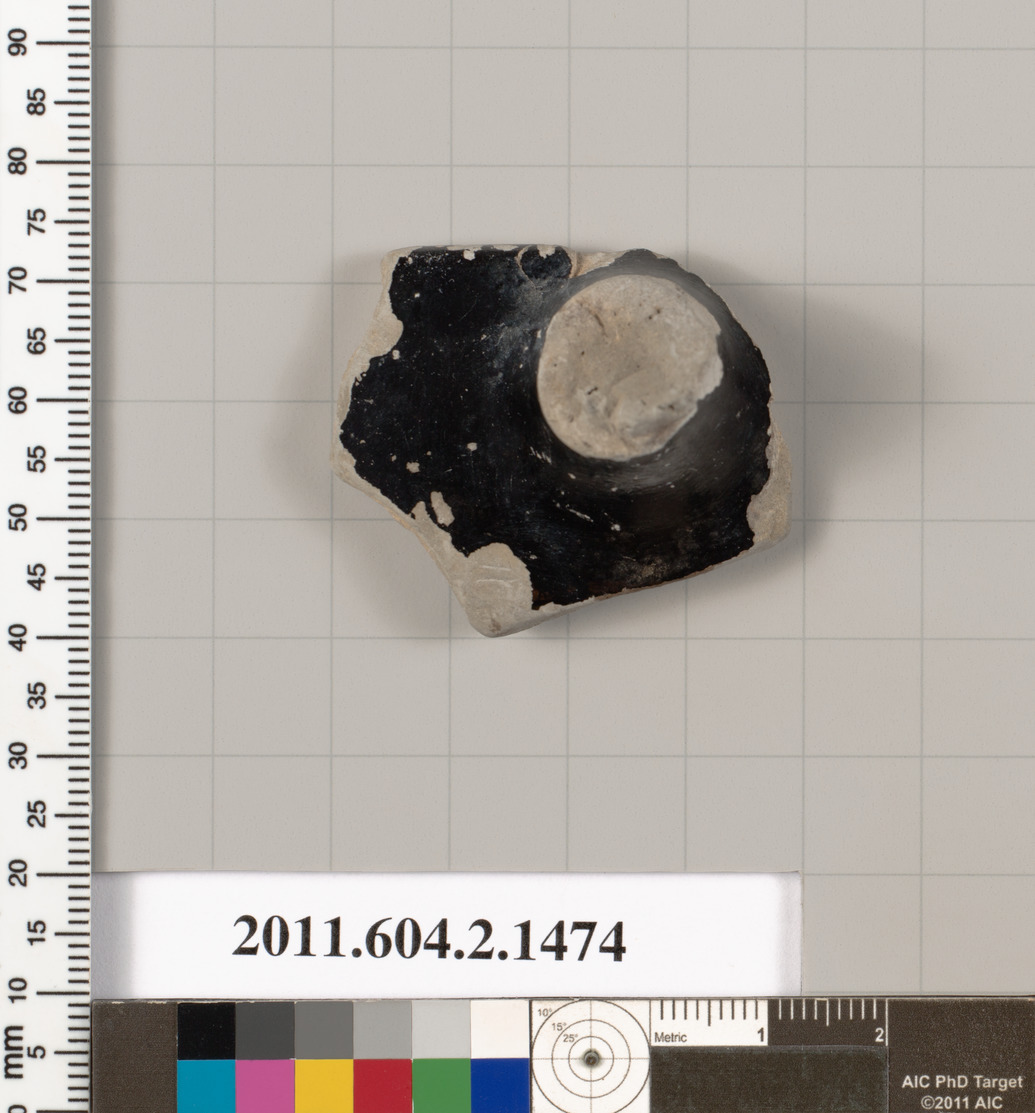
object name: skyphos fragment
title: Terracotta fragment of a skyphos (deep drinking cup)?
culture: greek, attic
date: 600-401 BCE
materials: terracotta